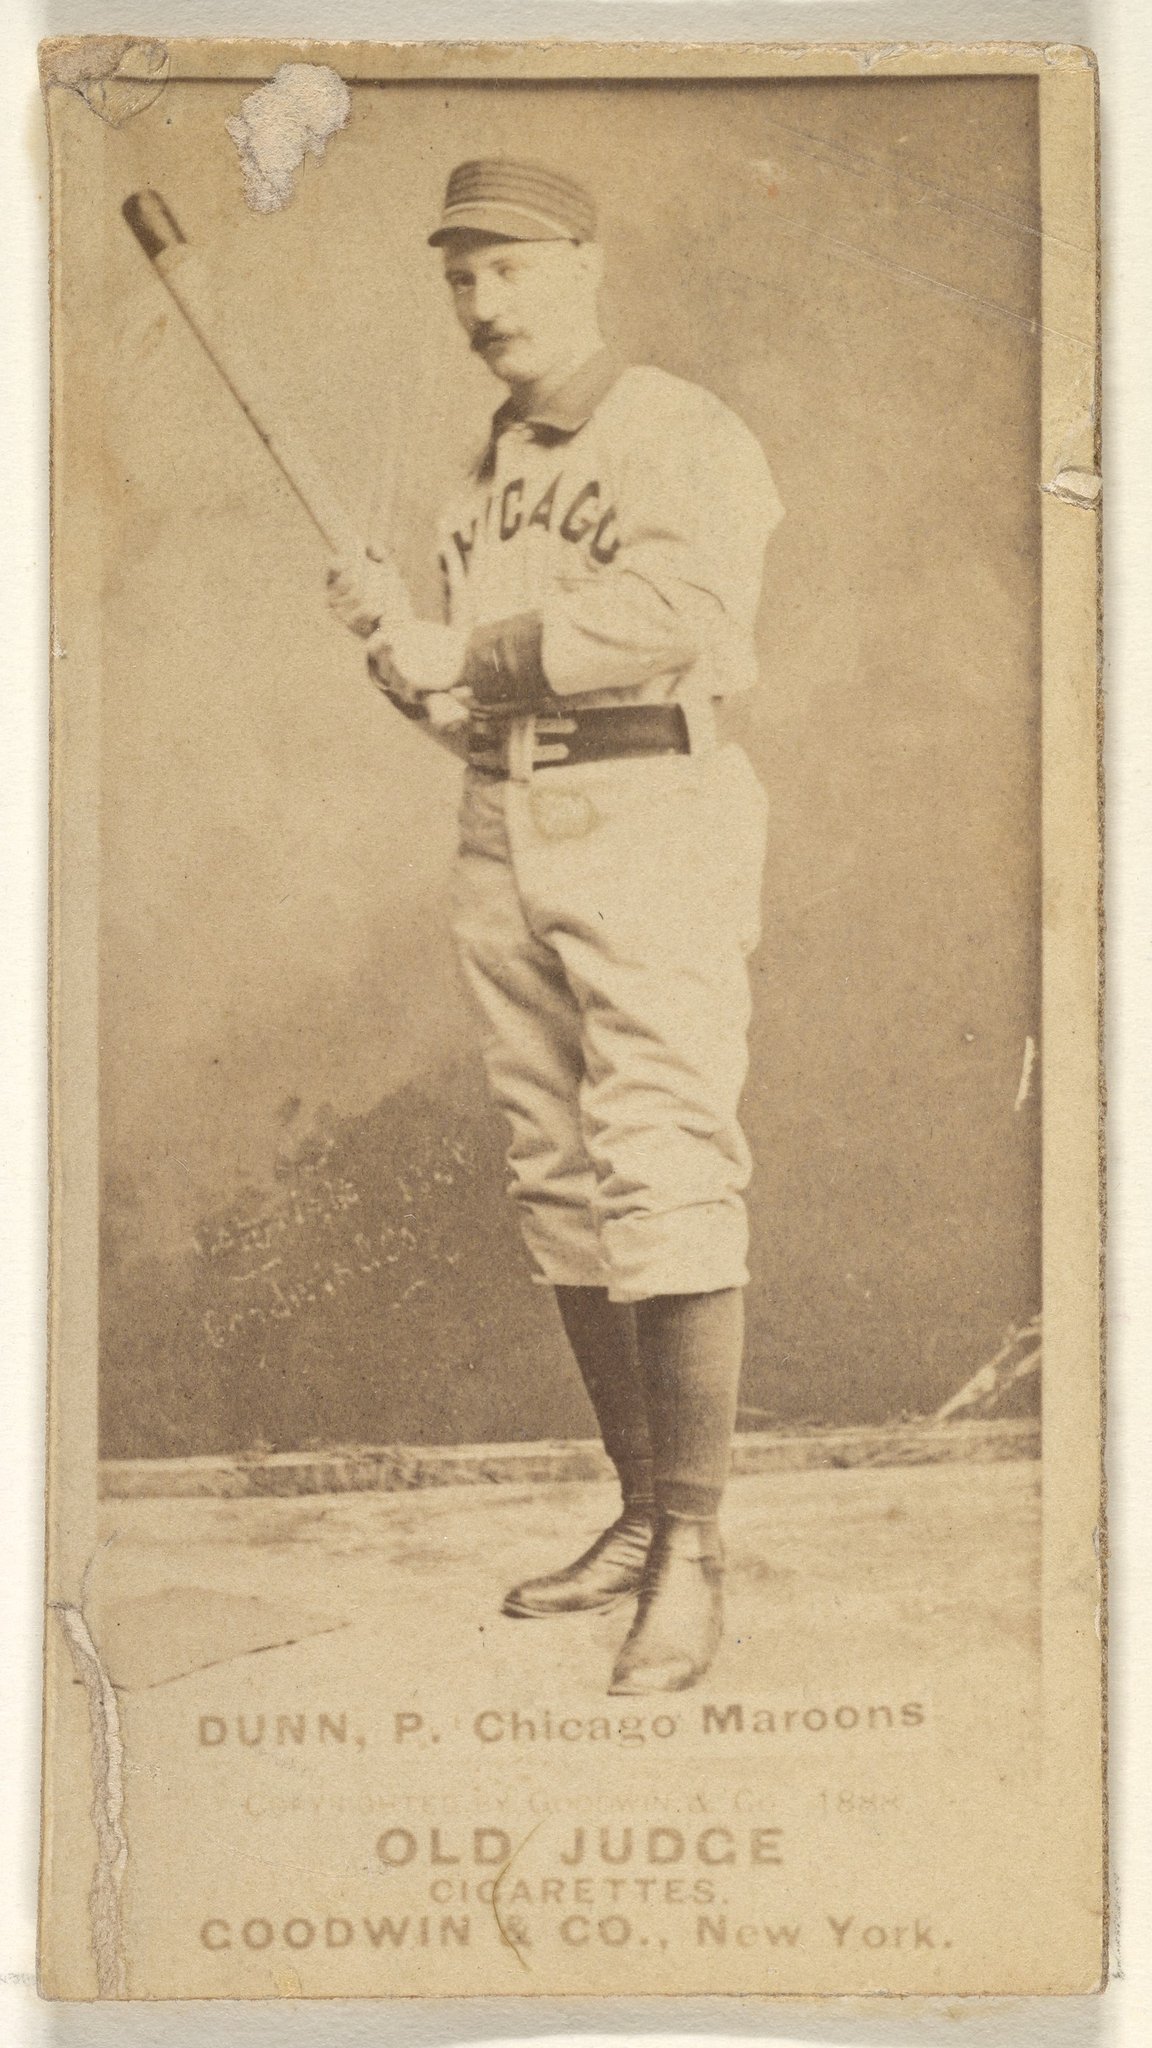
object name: baseball card, photograph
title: Dunn, Pitcher, Chicago, from the Old Judge series (N172) for Old Judge Cigarettes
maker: goodwin & company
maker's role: publisher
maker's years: 1850-1950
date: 1887-1890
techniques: albumen silver print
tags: men,portraits,baseball,athletes